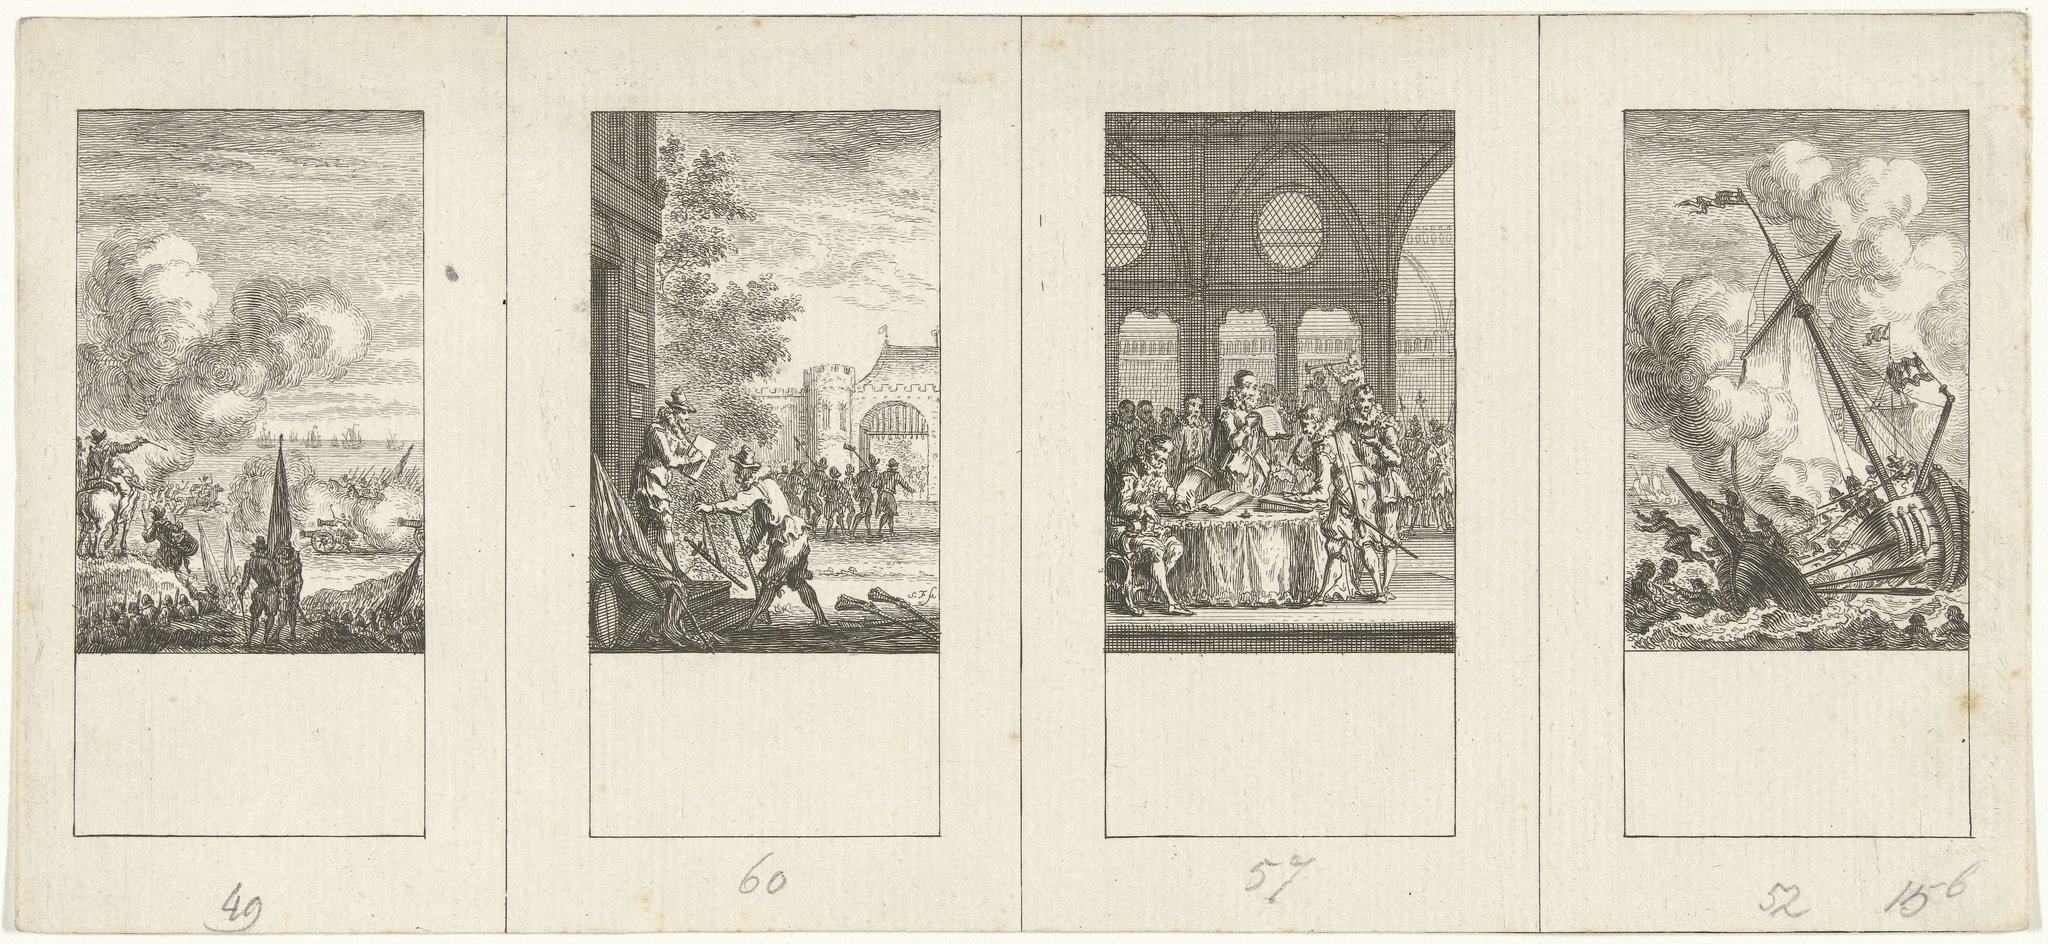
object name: print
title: Vier episodes uit de vaderlandse geschiedenis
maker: simon fokke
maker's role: draughtsman, print maker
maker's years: 1712-1784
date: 1722-1784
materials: paper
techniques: etching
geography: amsterdam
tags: historical events and situations, historical persons (portraits and scenes from the life), battle of nieuwpoort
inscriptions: number: ‘49, 60, 57, 52’, collector's mark: Lugt 2228